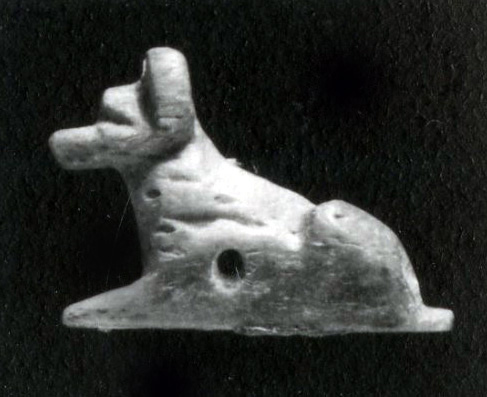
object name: amulet, anubis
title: Anubis amulet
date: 2110-2030 BCE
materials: ivory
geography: egypt